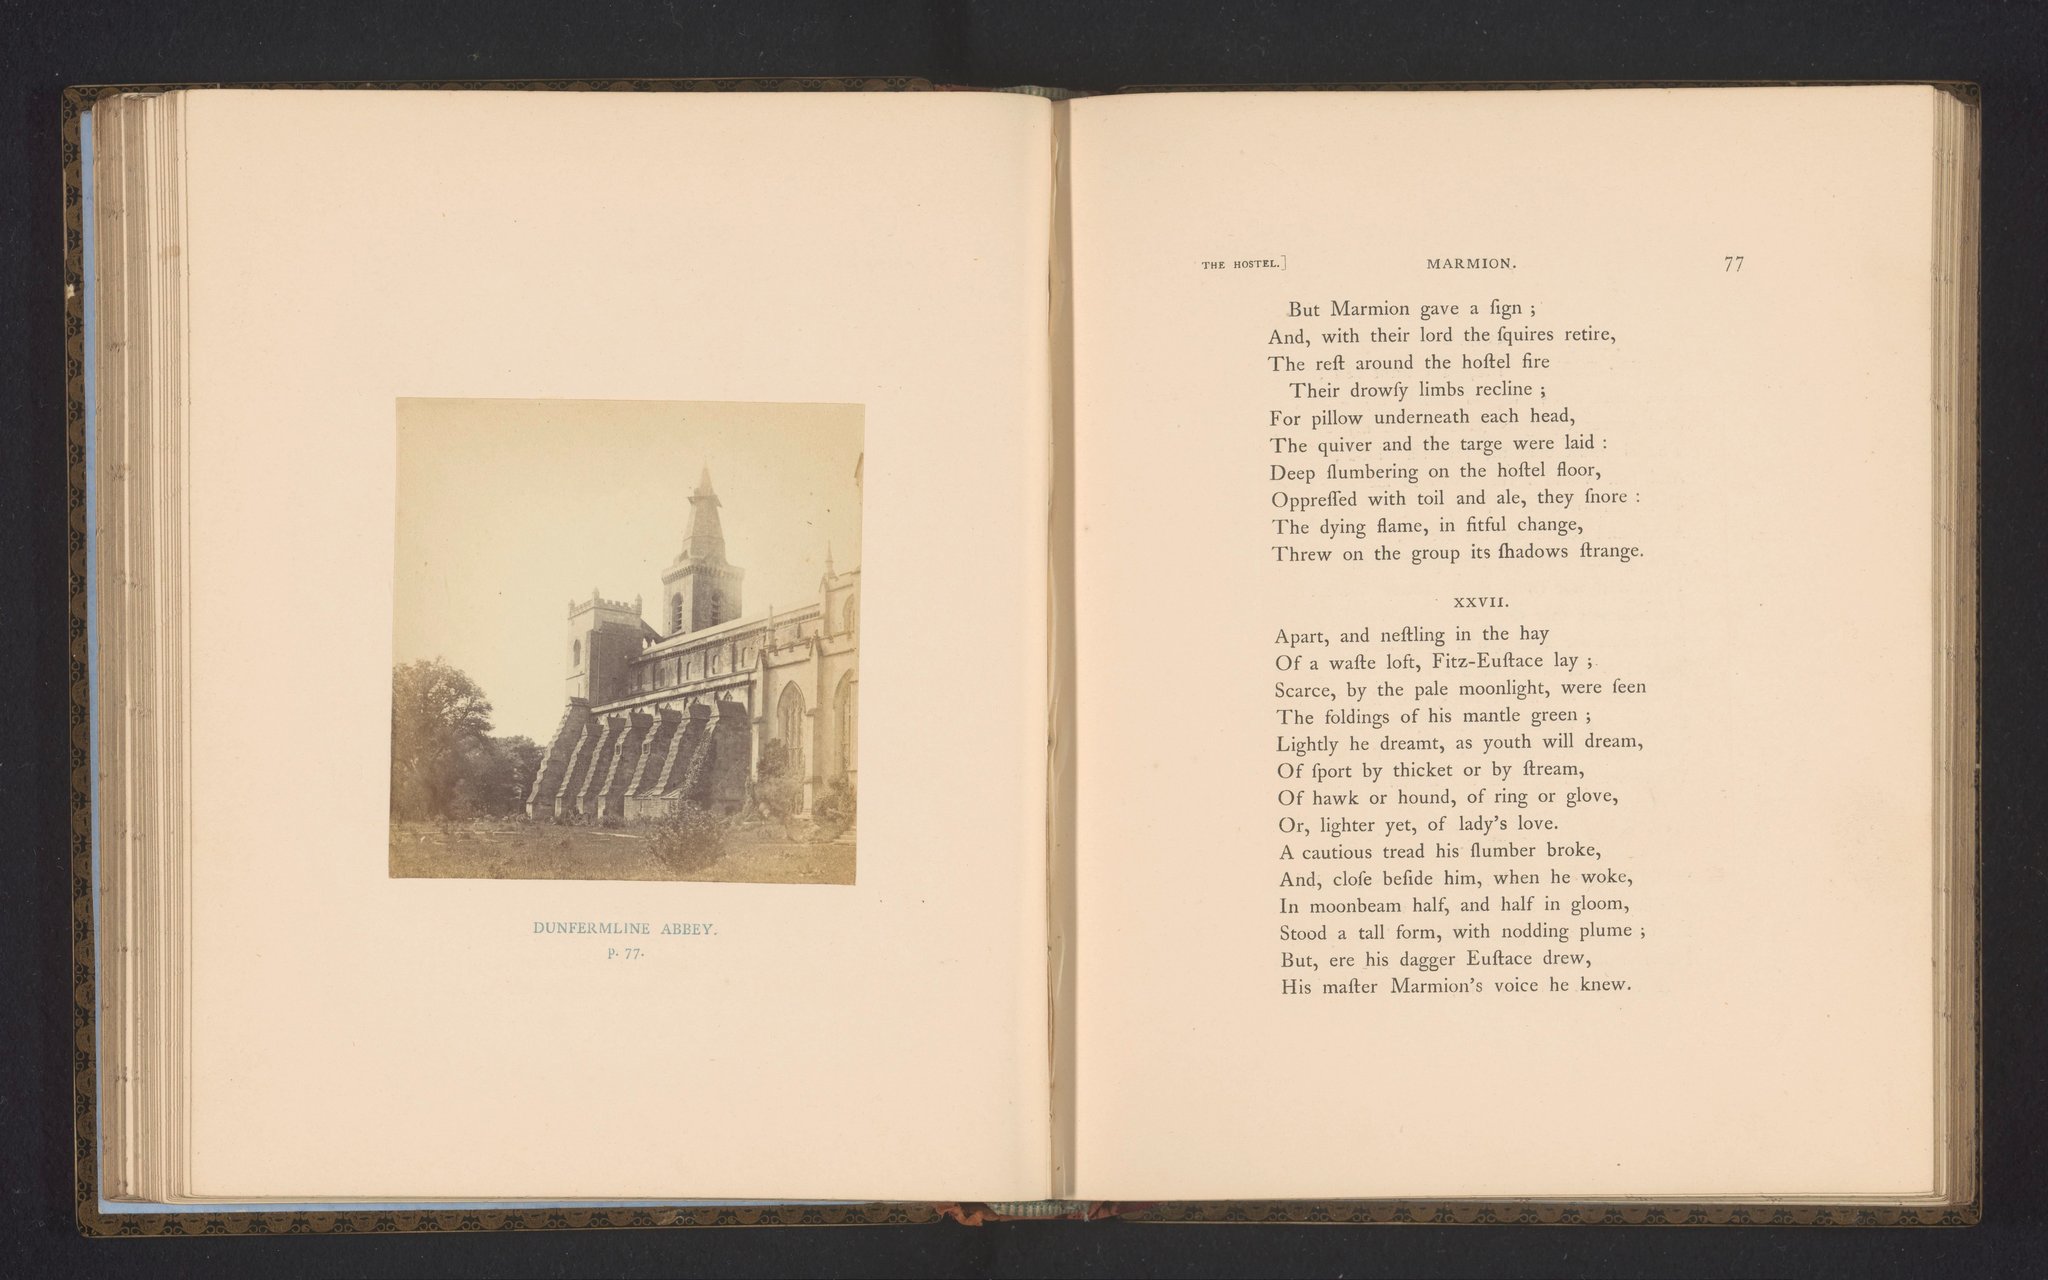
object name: page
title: Dunfermline Abbey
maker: thomas annan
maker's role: fotograaf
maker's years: 1829-1887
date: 1856-1866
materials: photographic support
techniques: albumen print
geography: dunfermline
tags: ruin of church, monastery, etc.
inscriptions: inscription: ‘p. 77.’